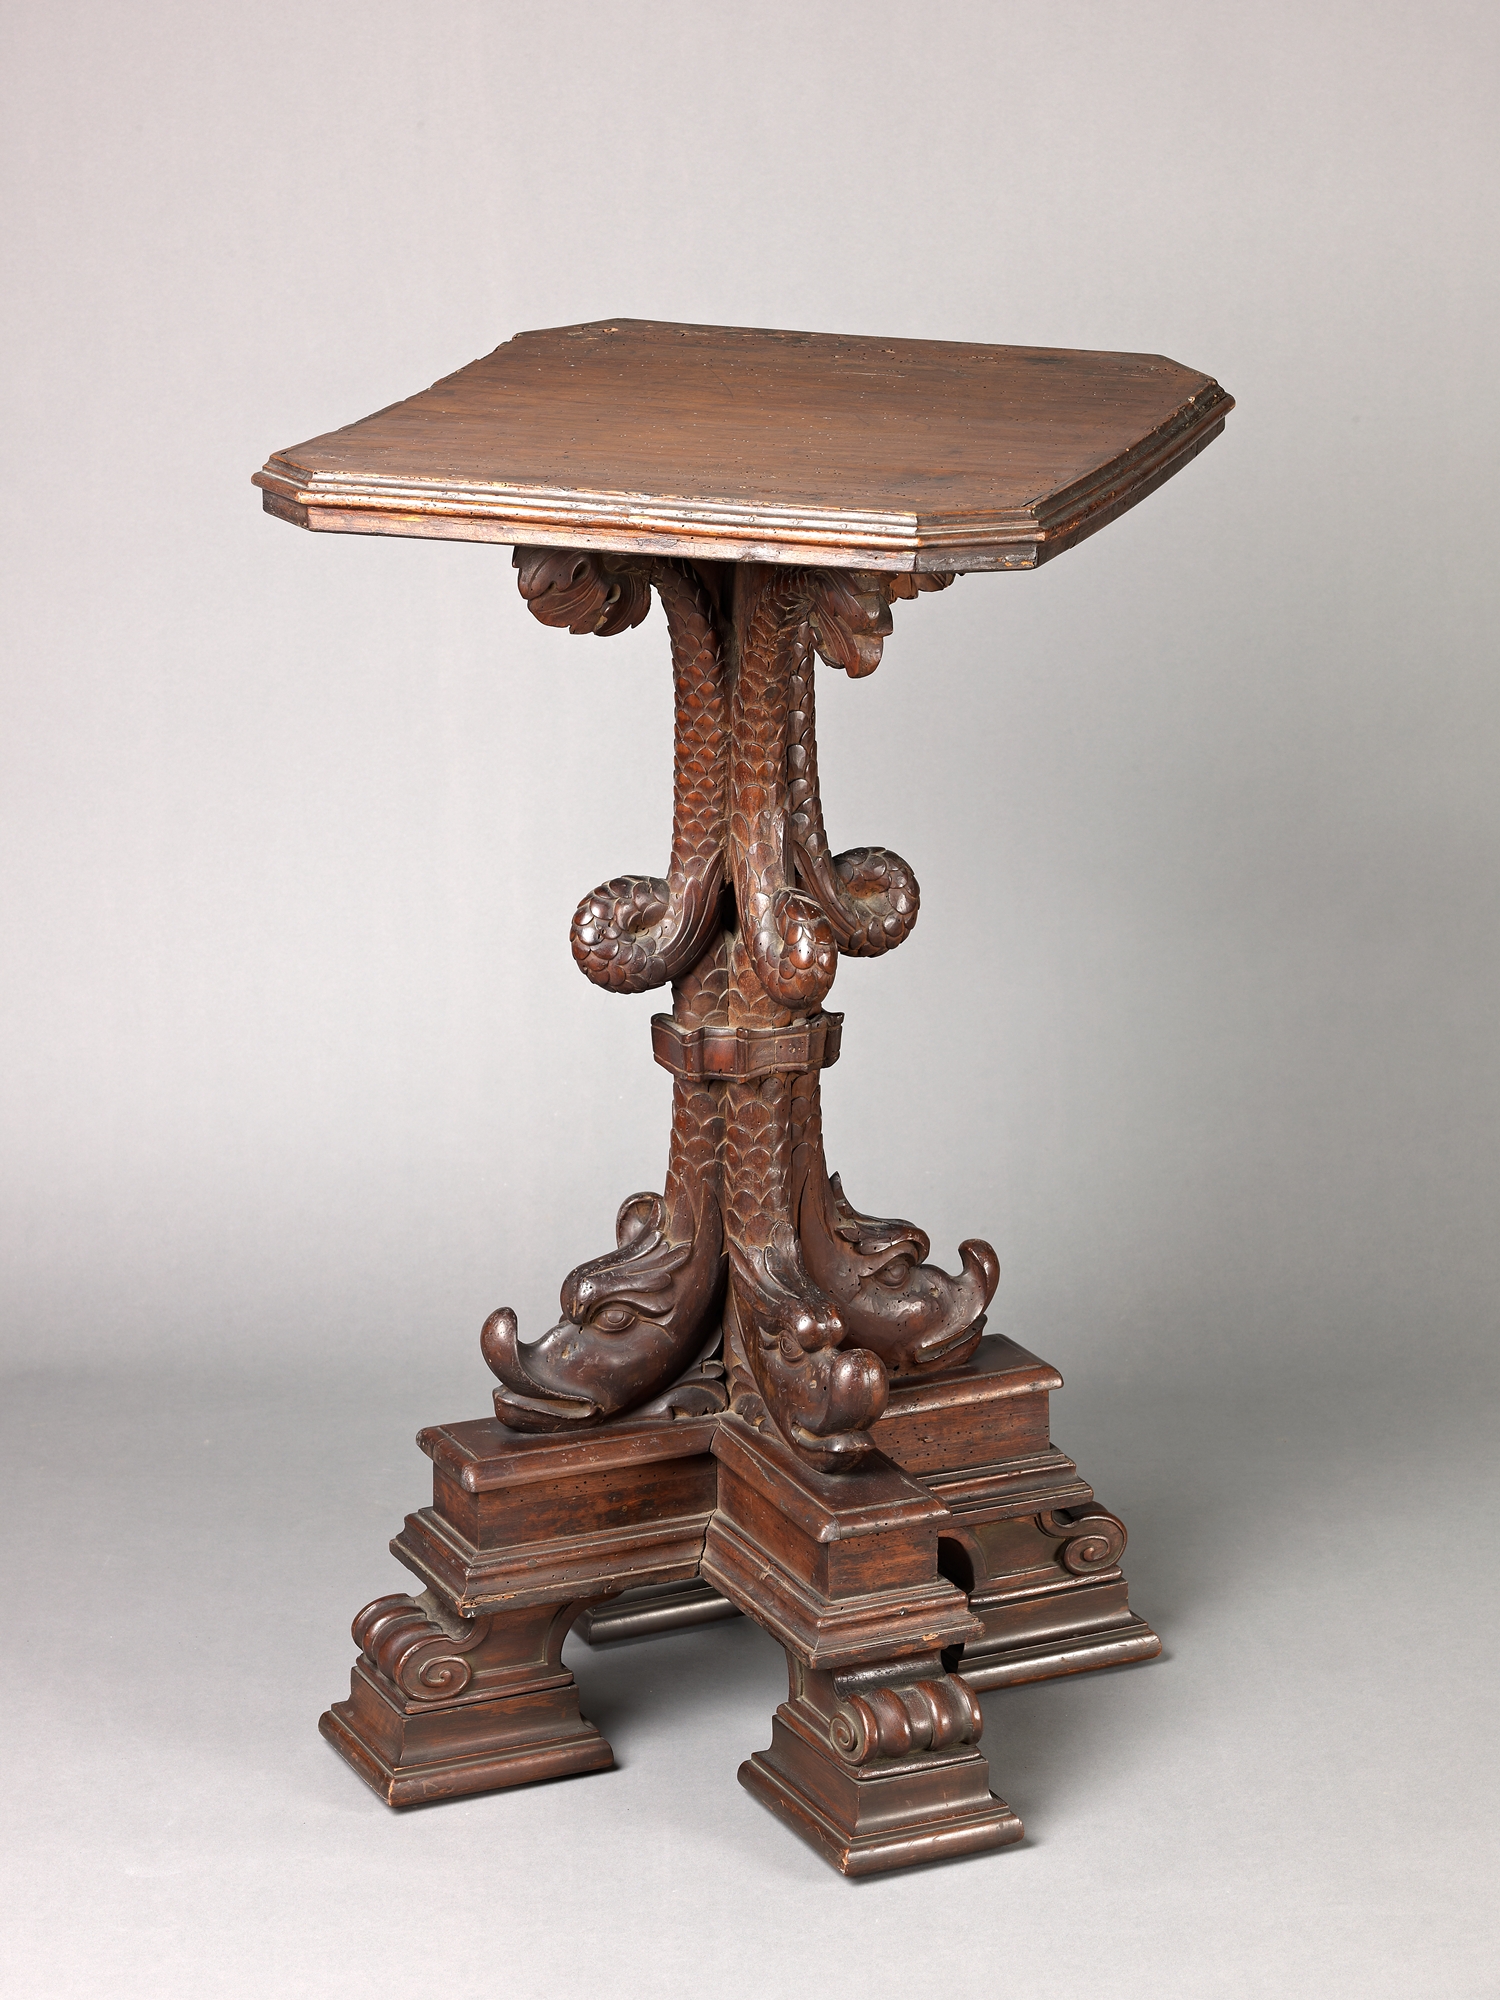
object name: table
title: Square table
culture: italian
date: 1840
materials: wood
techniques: carving